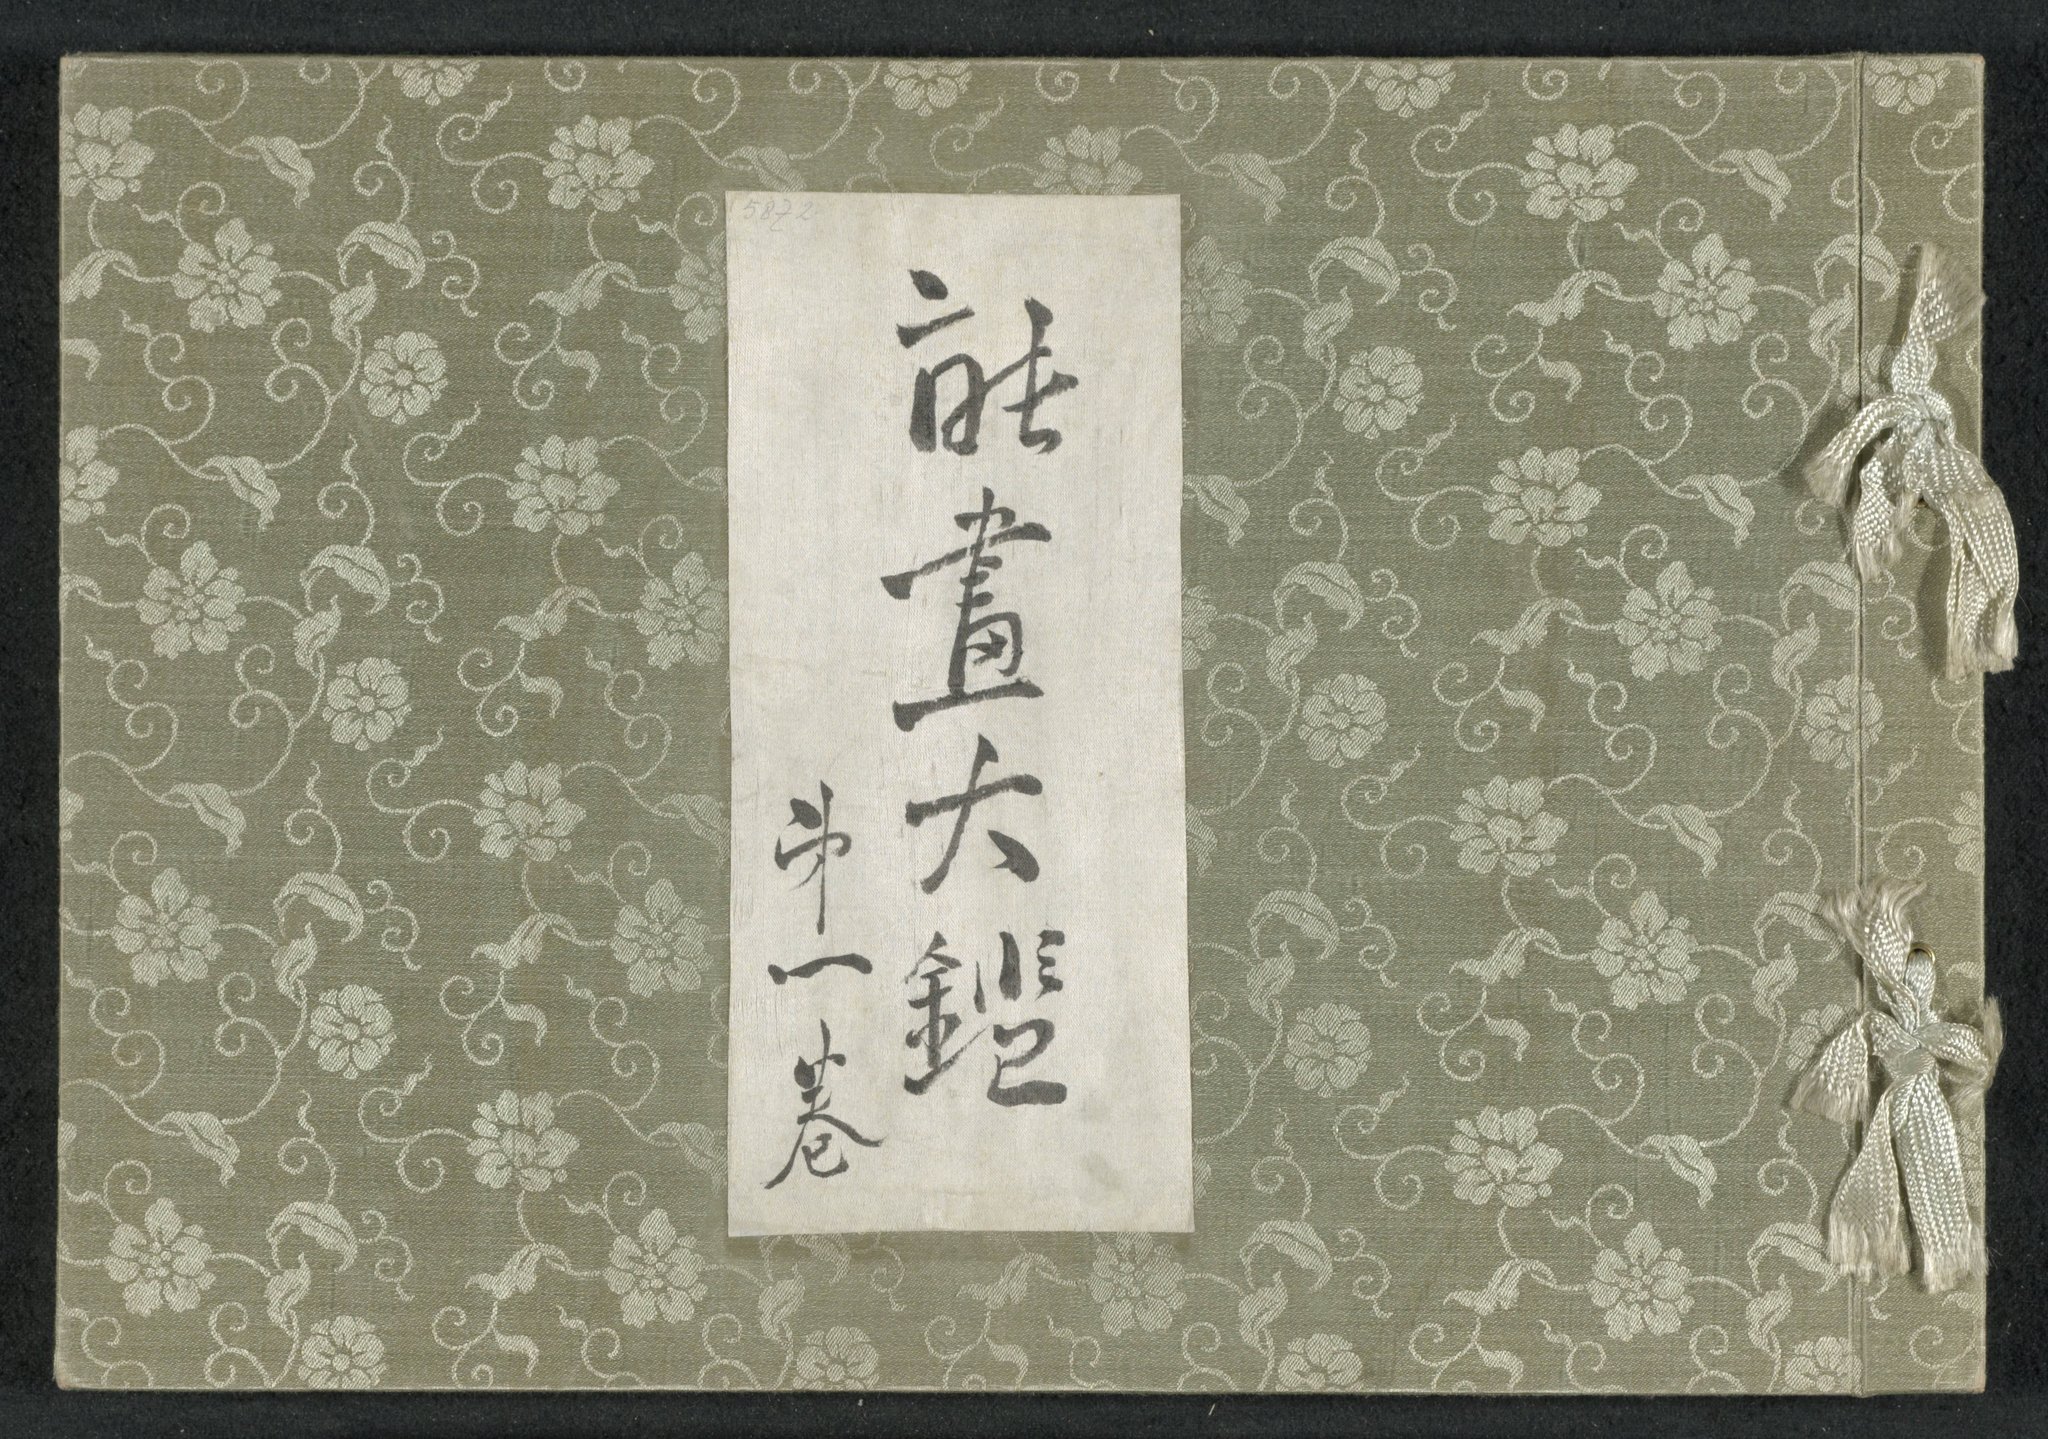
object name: picture book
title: Nôga taikan dai yon maki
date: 1925-1926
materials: cardboard, paper, ribbon, silk, textile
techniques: woodcut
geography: japan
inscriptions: collector's mark: ‘Rijks-Ethnographisch Museum’